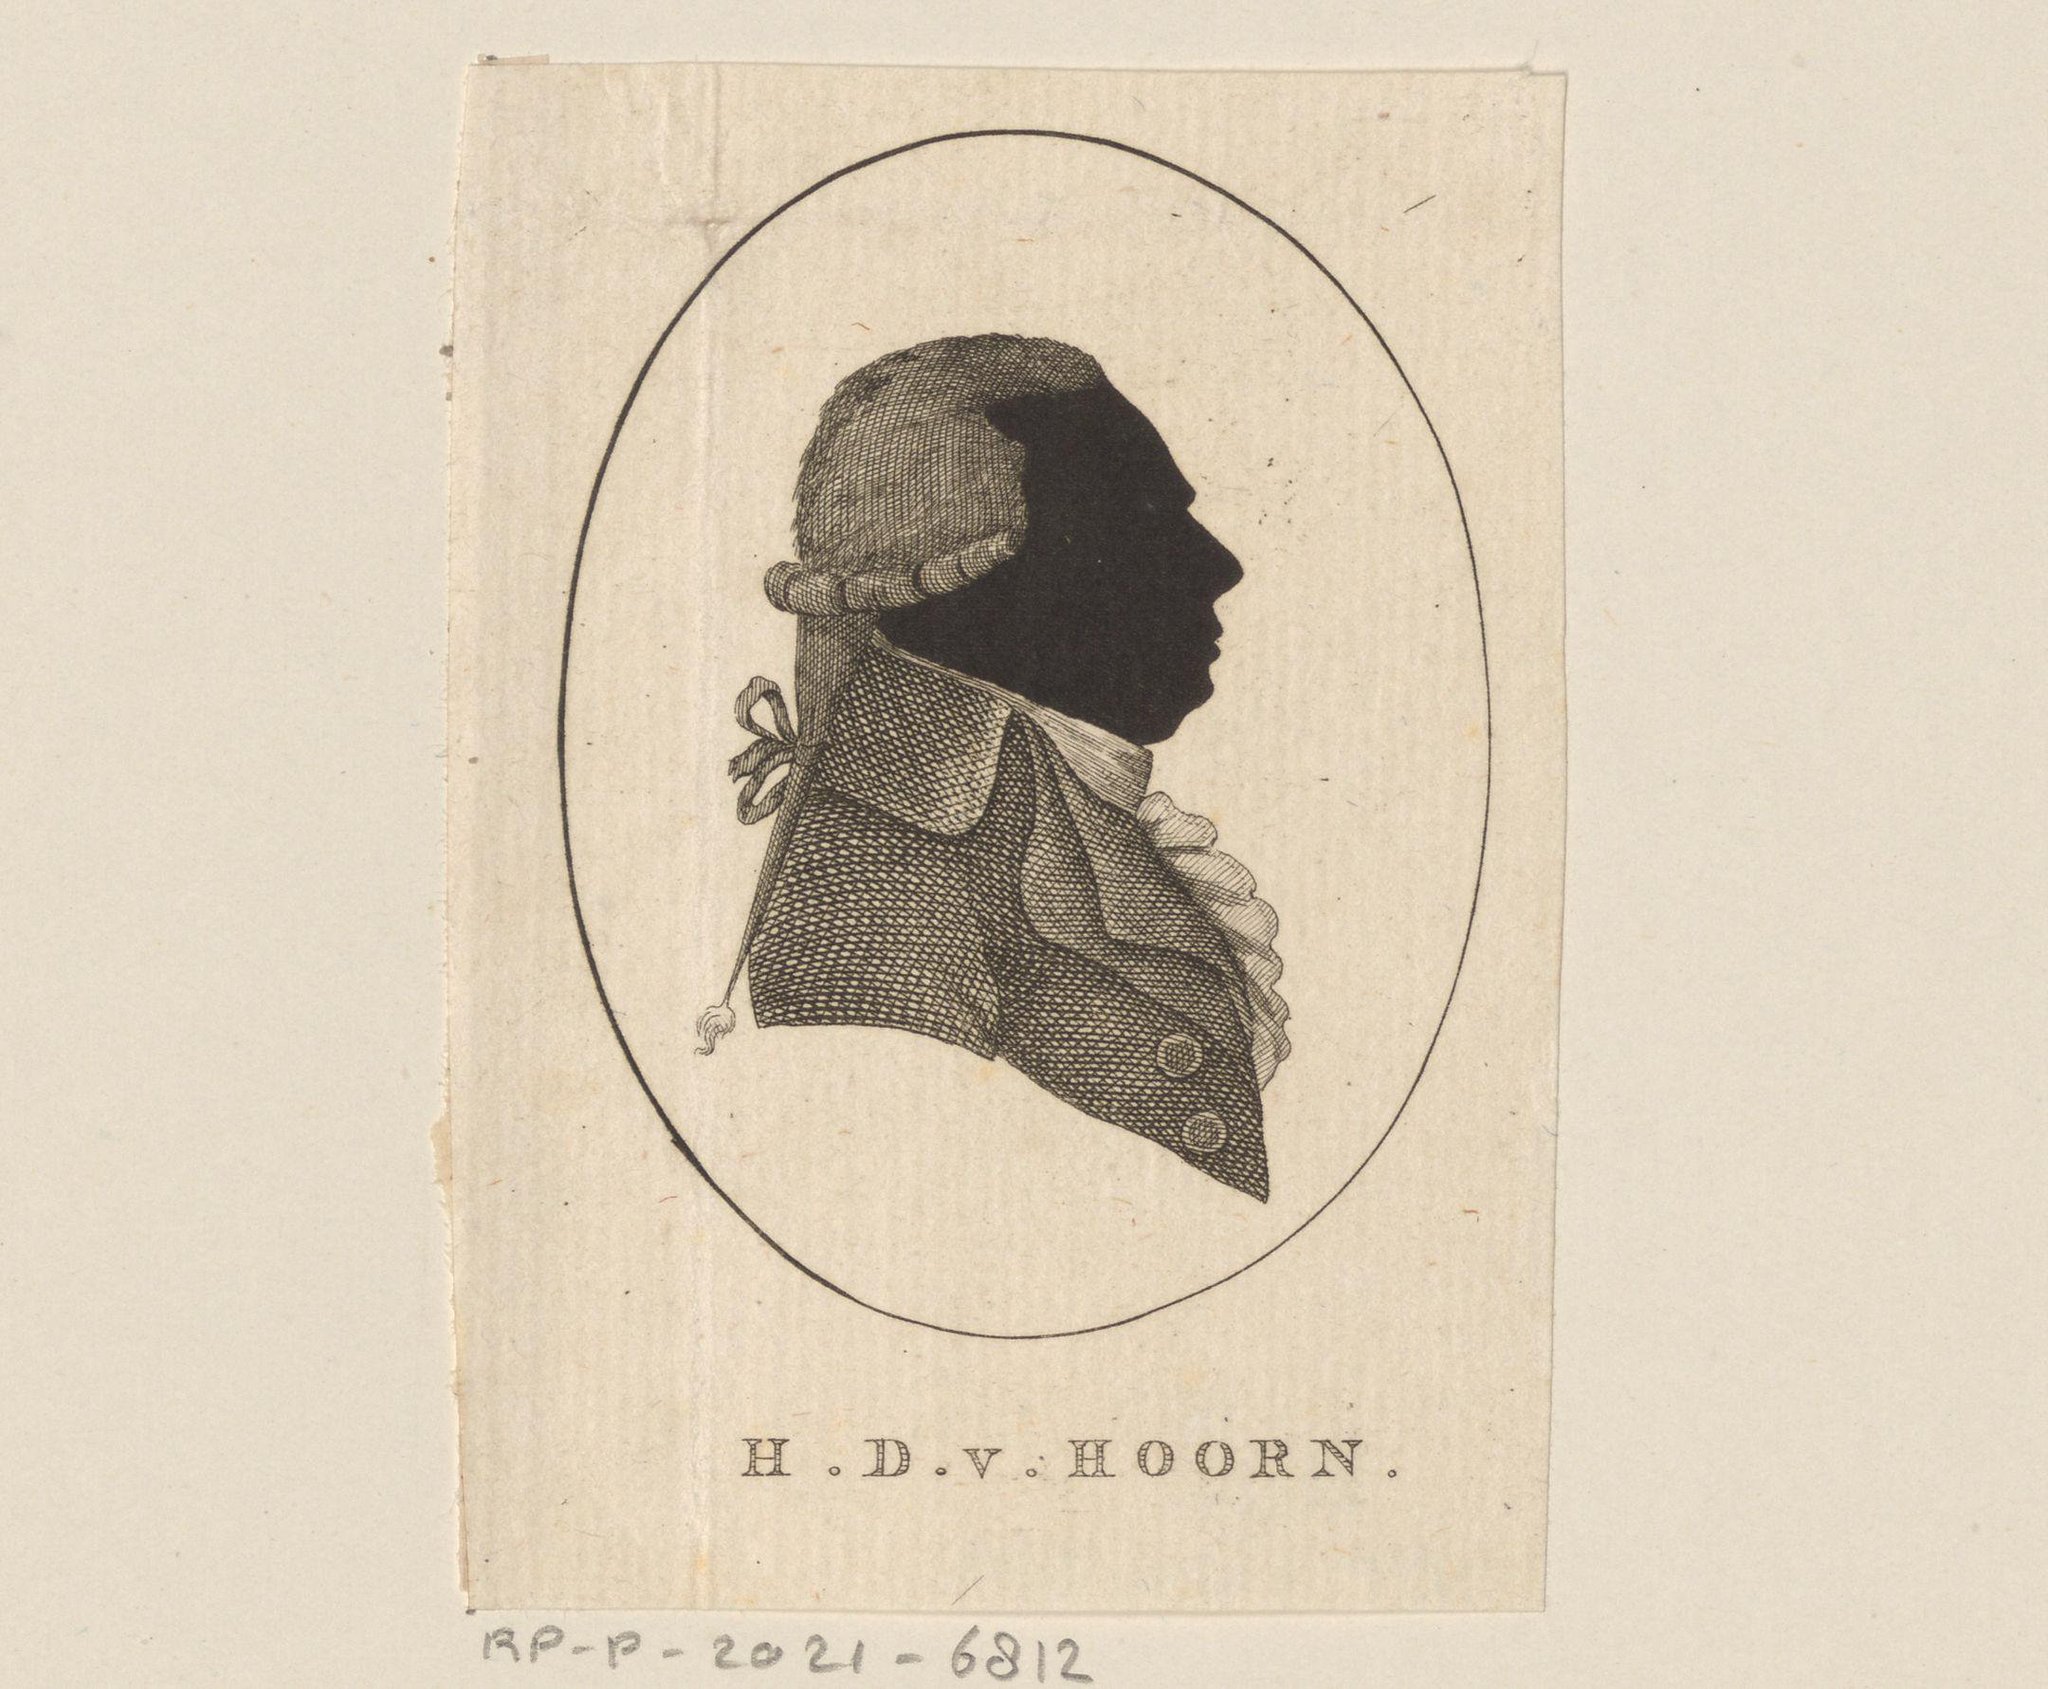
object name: book illustration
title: Silhouetportret van Hendrik Daniël van Hoorn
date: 1799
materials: paper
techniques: etching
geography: amsterdam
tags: amsterdam, politician, historical persons, politician, e.g. party leader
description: Prent uit: Rogge, Cornelis. Geschiedenis der staatsregeling, voor het Bataafsche volk. Amsterdam: Johannes Allart, 1799.